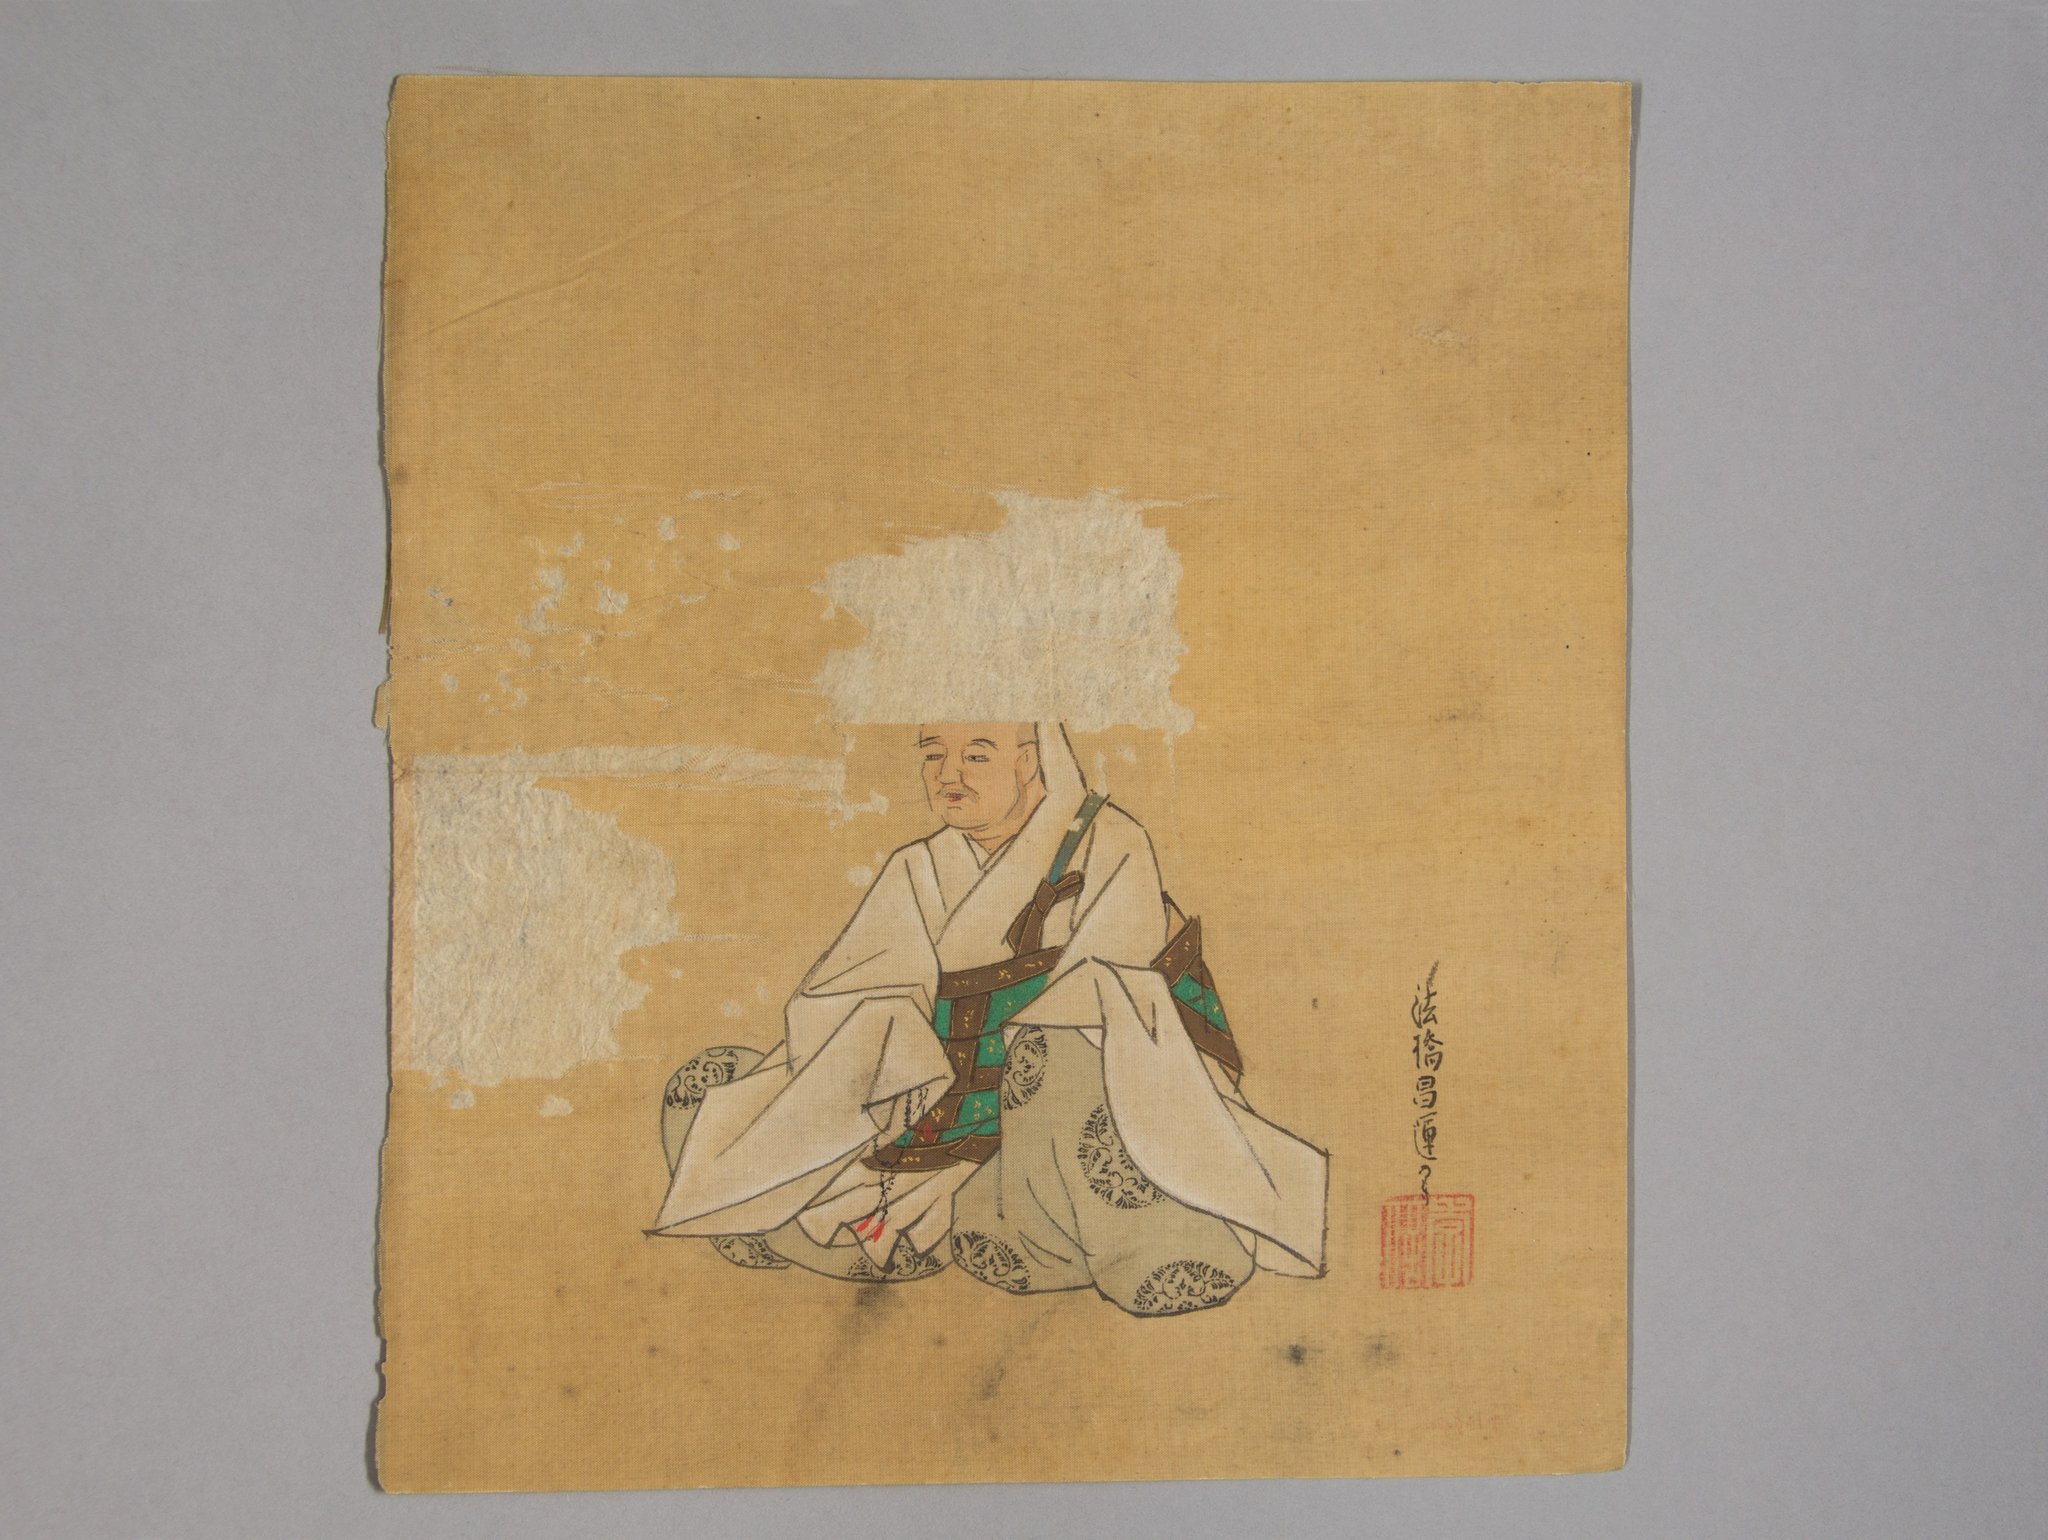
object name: painting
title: Immortal Poet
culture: japanese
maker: kano shōun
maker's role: artist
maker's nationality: japanese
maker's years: 1637-1702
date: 1601-1700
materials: ink, silk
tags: men,poets